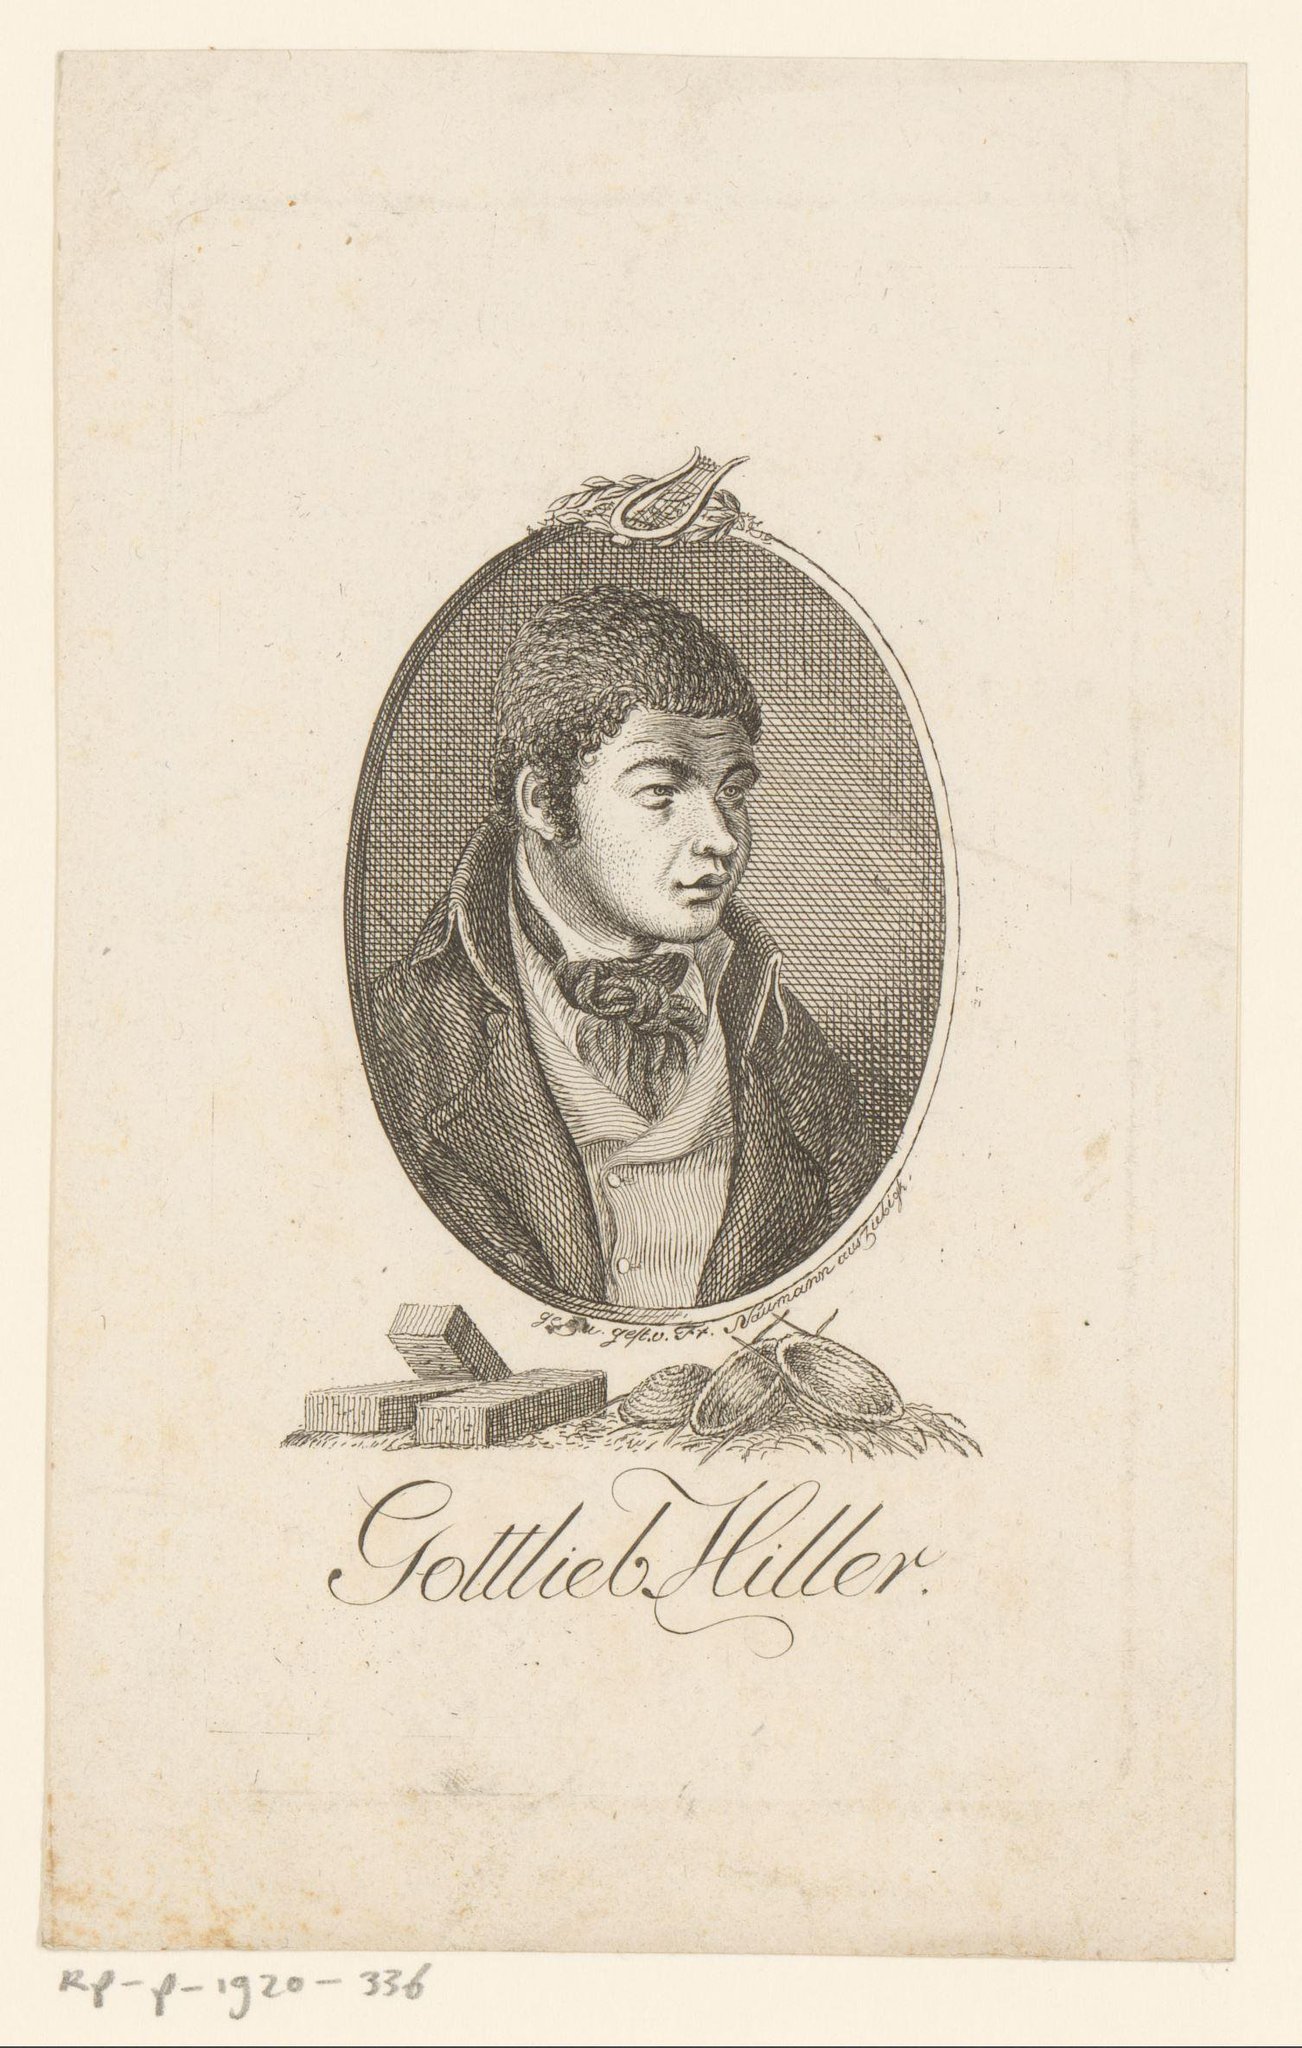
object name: print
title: Portret van Gottlieb Hiller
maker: fr. naumann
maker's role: print maker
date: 1800-1899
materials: paper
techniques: etching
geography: dessau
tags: historical persons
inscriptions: collector's mark: Lugt 2228